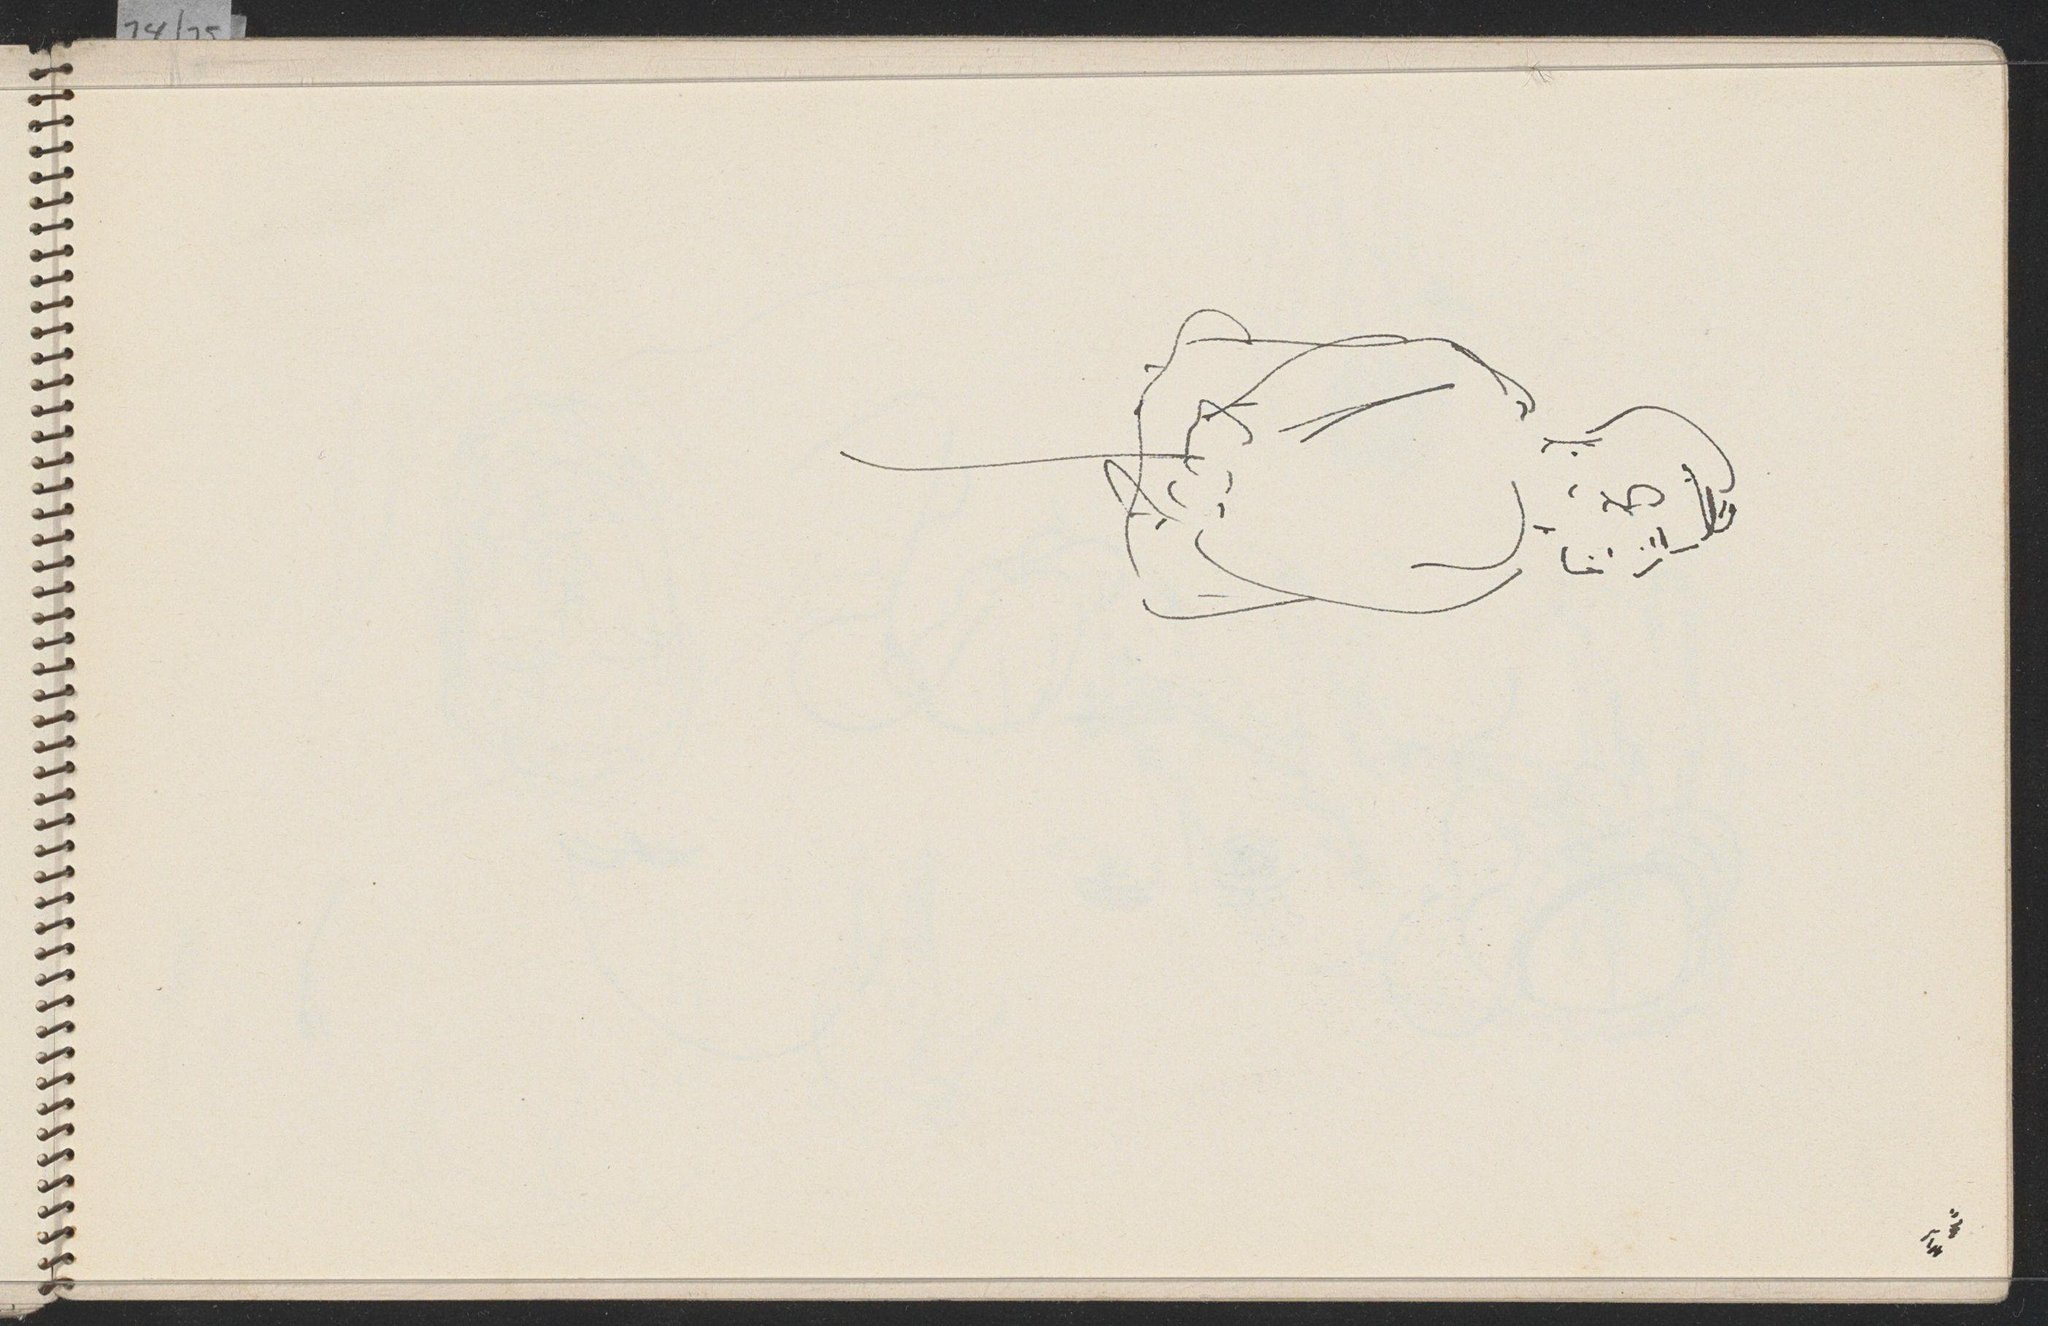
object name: sketchbook leaf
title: Figuur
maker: carel adolph lion cachet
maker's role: draughtsman, print maker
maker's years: 1864-1945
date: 1930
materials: ink, paper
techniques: pen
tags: anatomy (non-medical)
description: Blad 14 recto uit een schetsboek met 20 bladen.